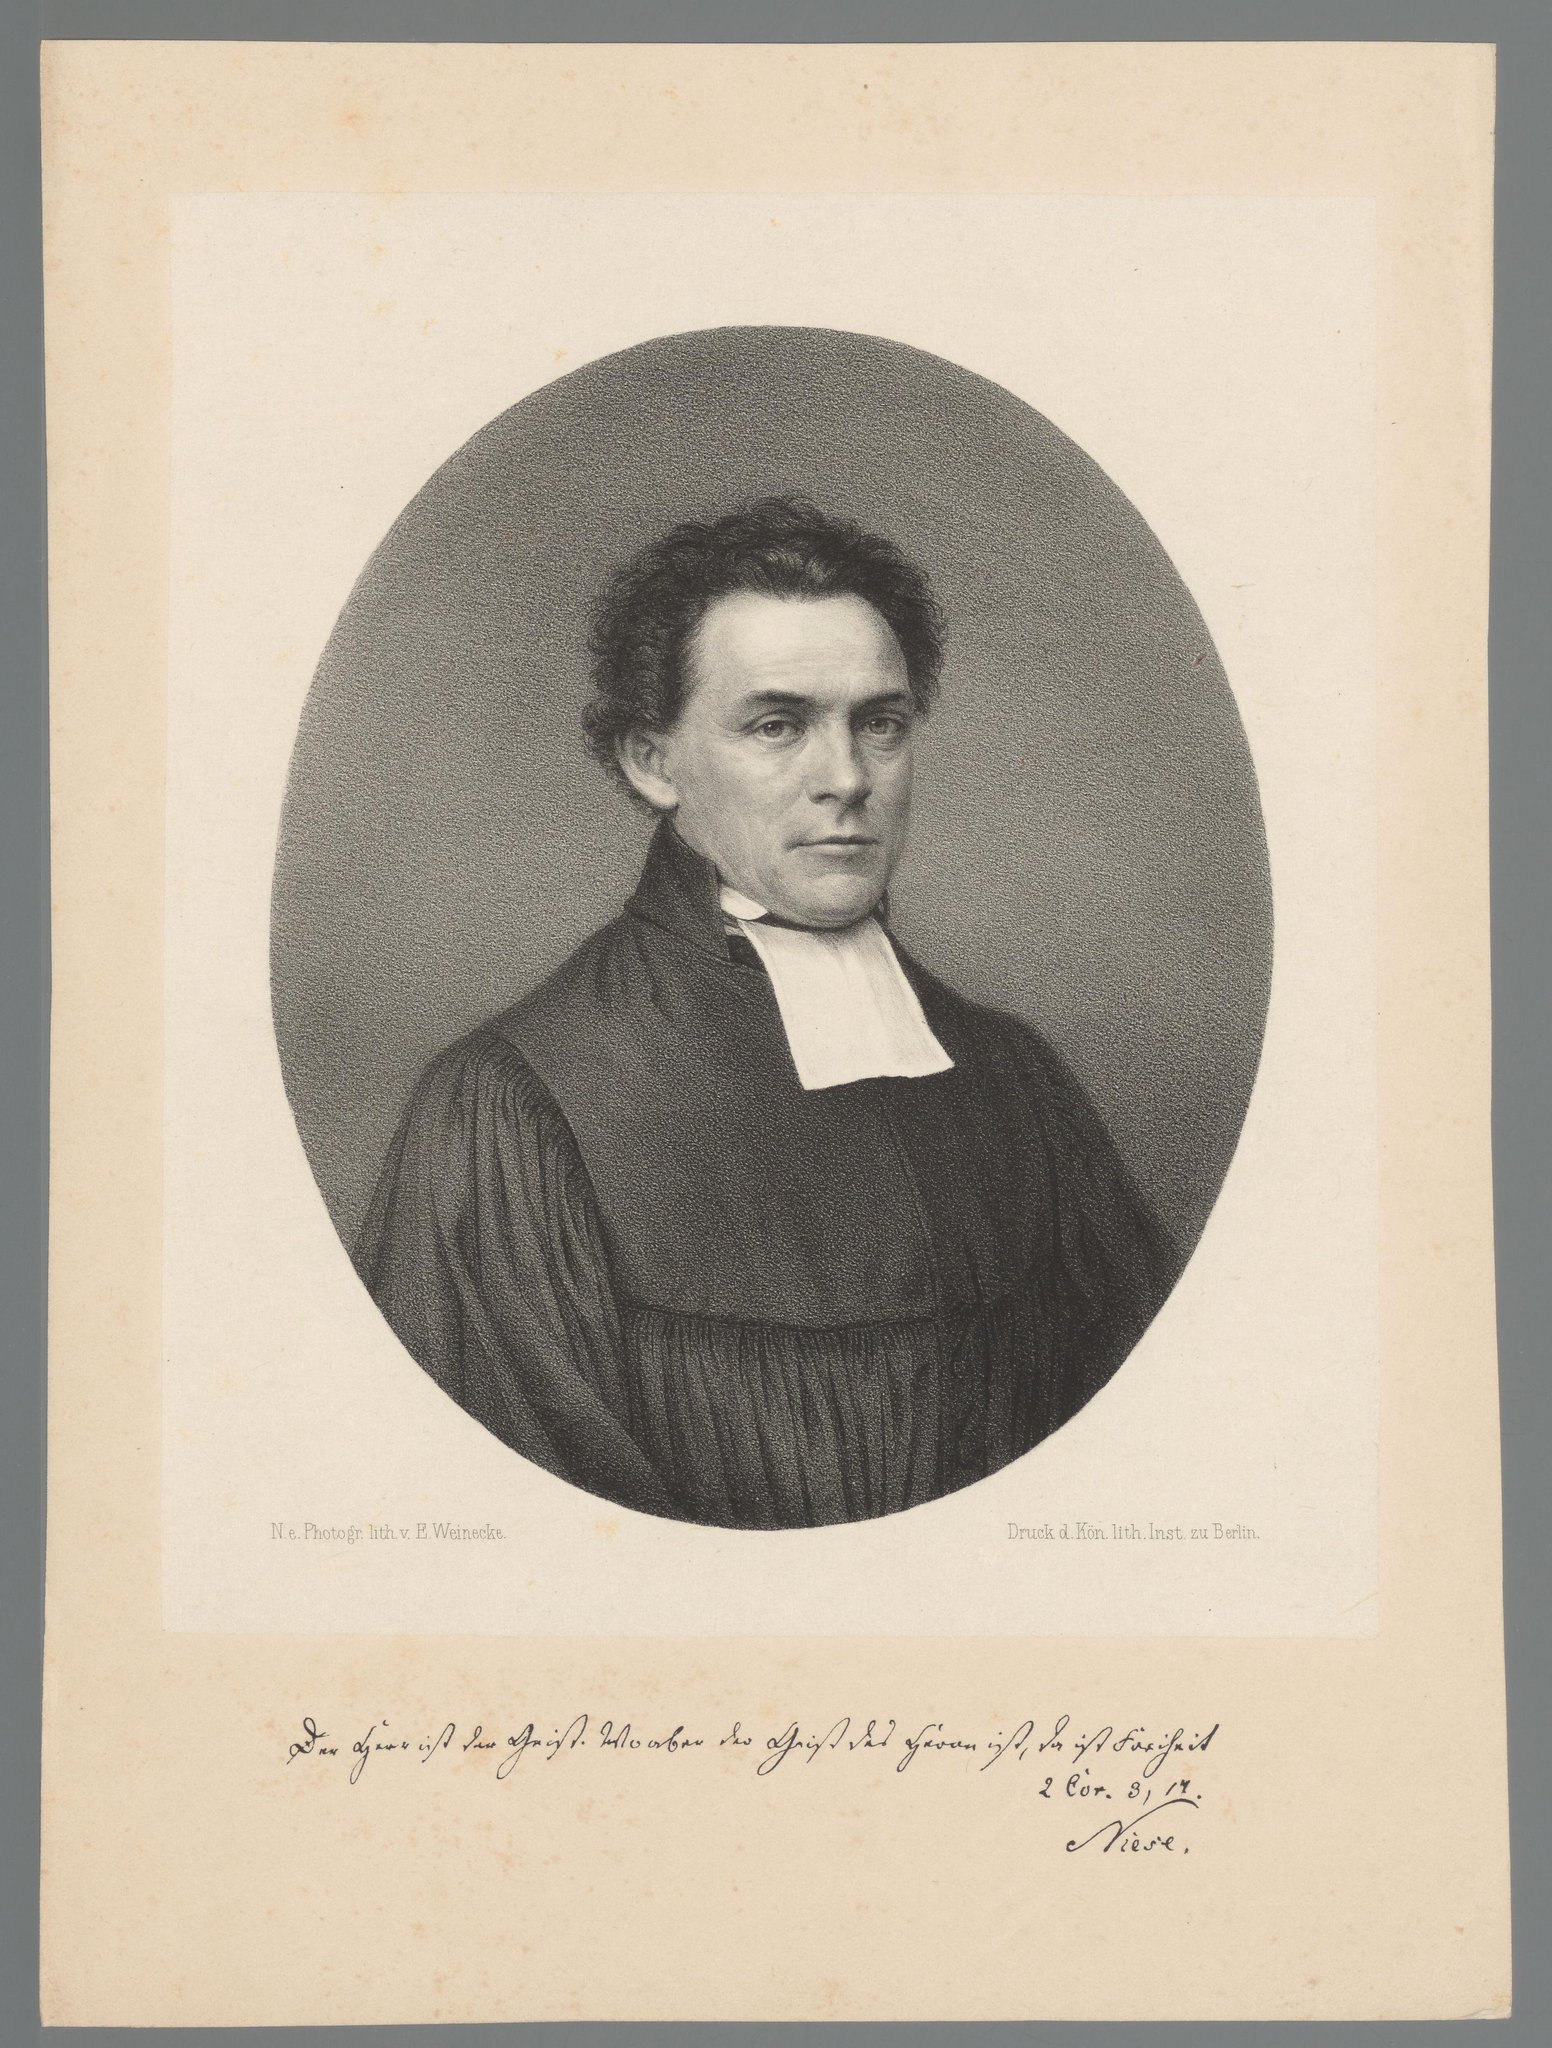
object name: print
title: Portret van een onbekende man, mogelijk Niese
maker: e. weinecke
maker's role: print maker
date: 1818-1861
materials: paper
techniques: lithograph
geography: berlin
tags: birthday, historical persons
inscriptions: collector's mark: Lugt 2228